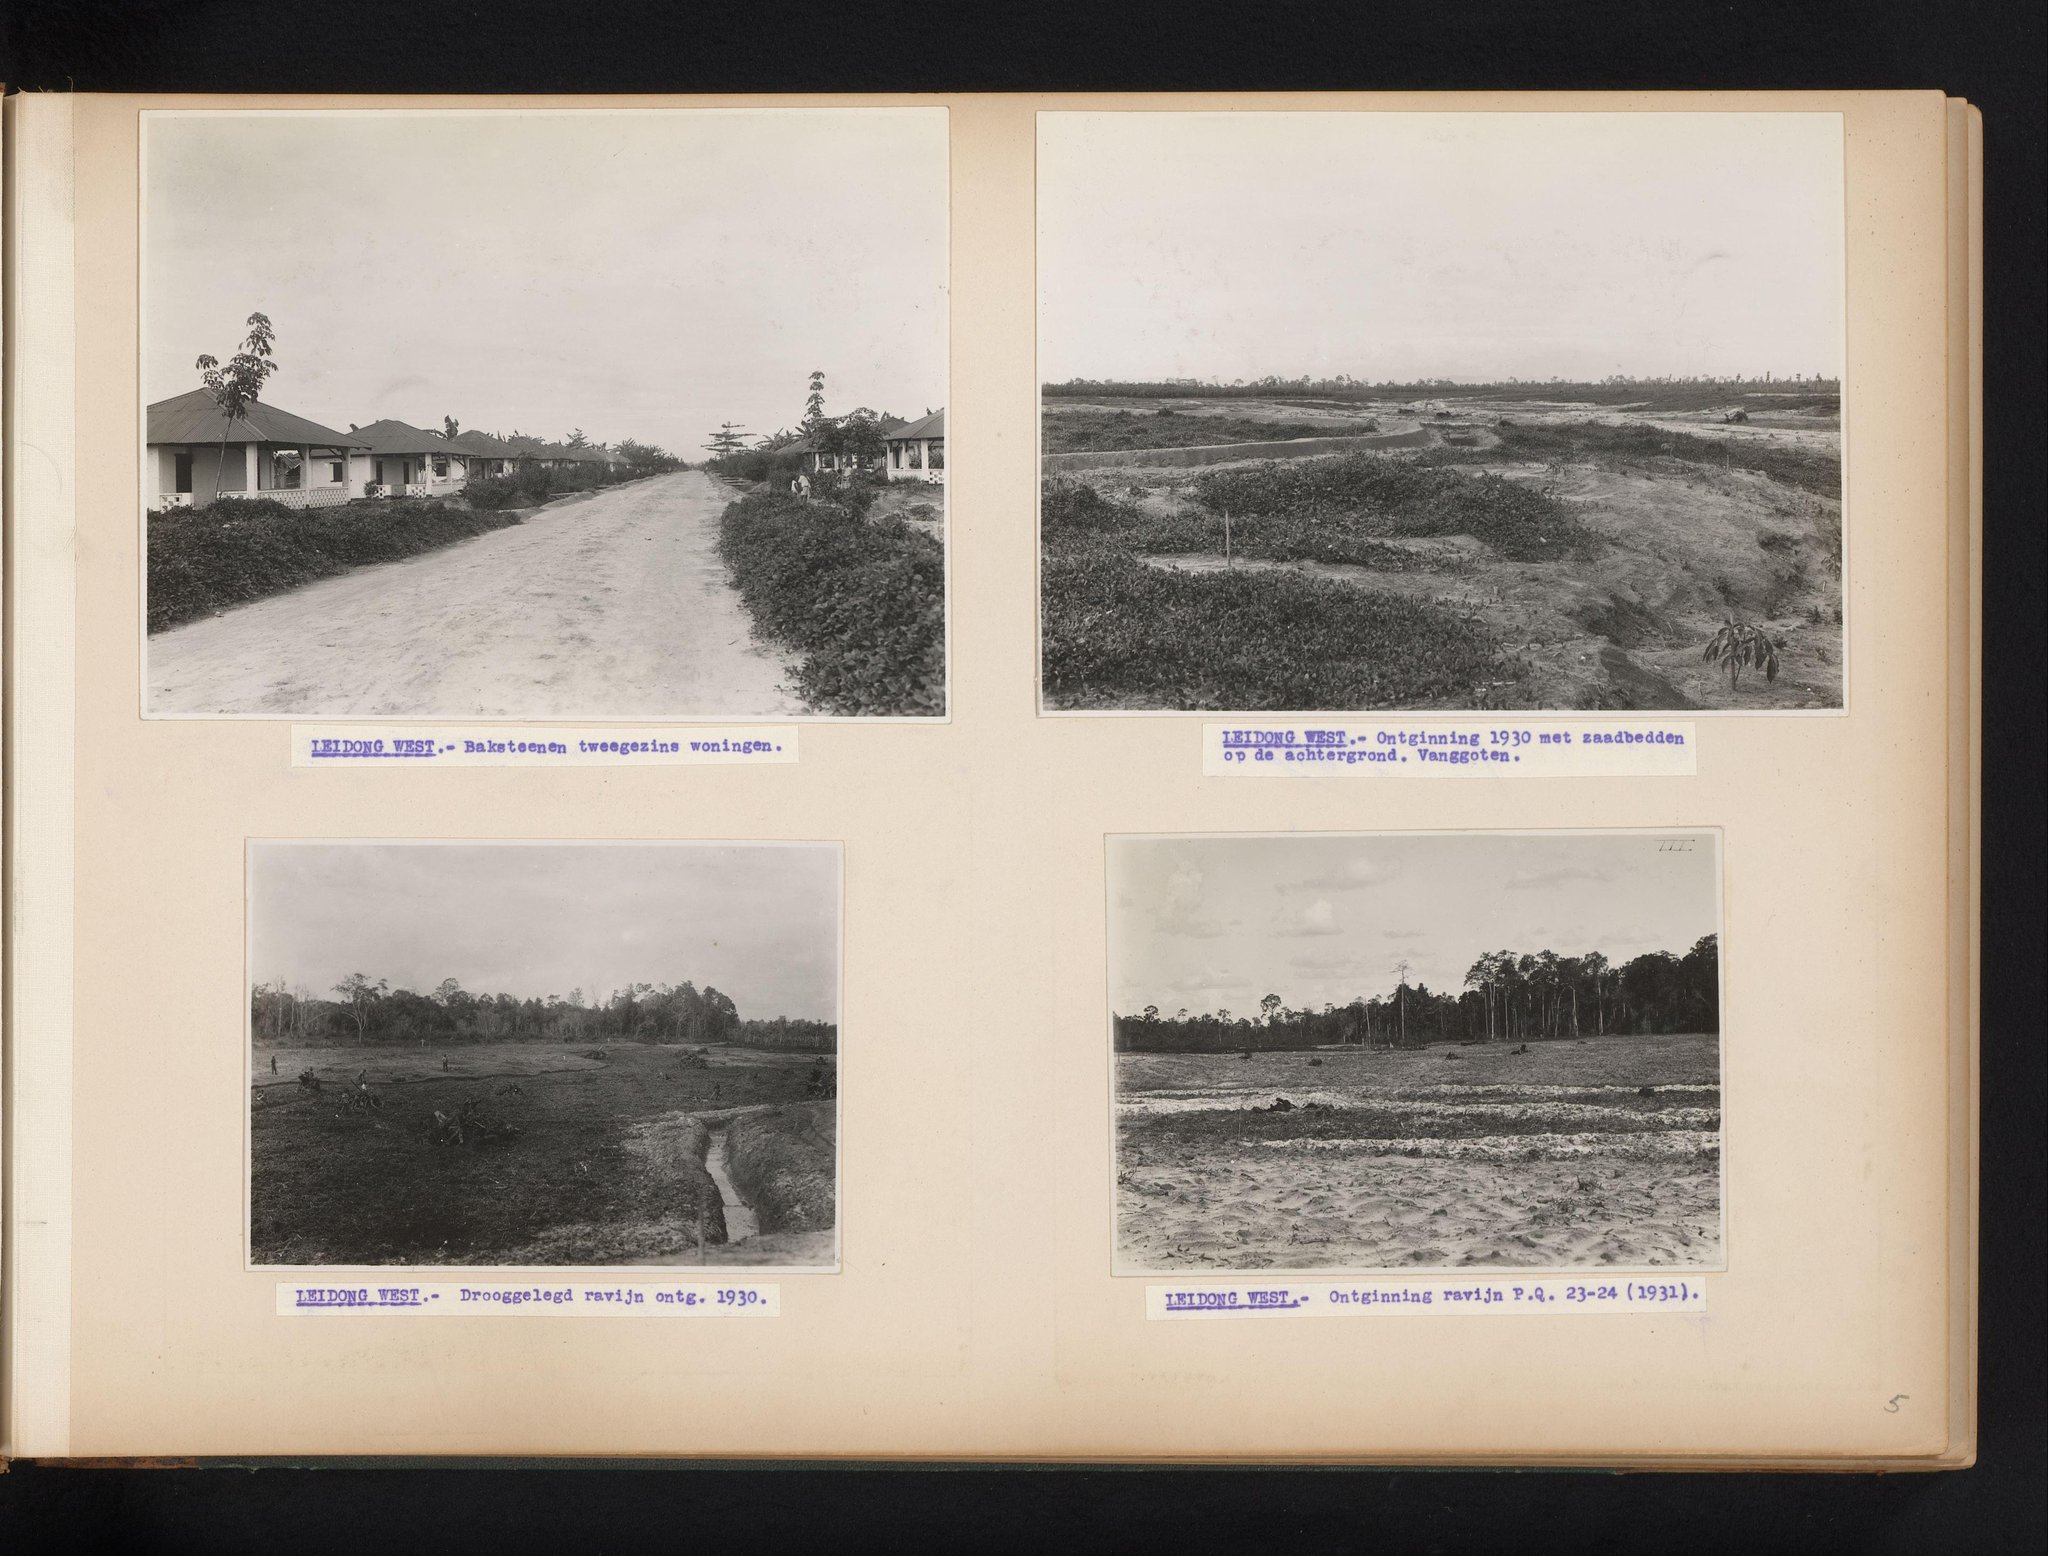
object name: album leaf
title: Woningen en ontginning op Leidong West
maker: Anonymous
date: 1931-1939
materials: cardboard, photographic support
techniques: gelatin silver print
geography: sumatra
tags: plantation, (non-fruit) products of plants or trees: rubber, rural housing, e.g. country-house, villa, cottage, sumatra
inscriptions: inscription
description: Blad met vier foto's van woningen en ontginning op Leidong West. Onderdeel van het fotoalbum over de plantages Leidong West en Kanopan Oeloe van de Cultuur Maatschappij Leidong West op Sumatra in de jaren 1925-1939.